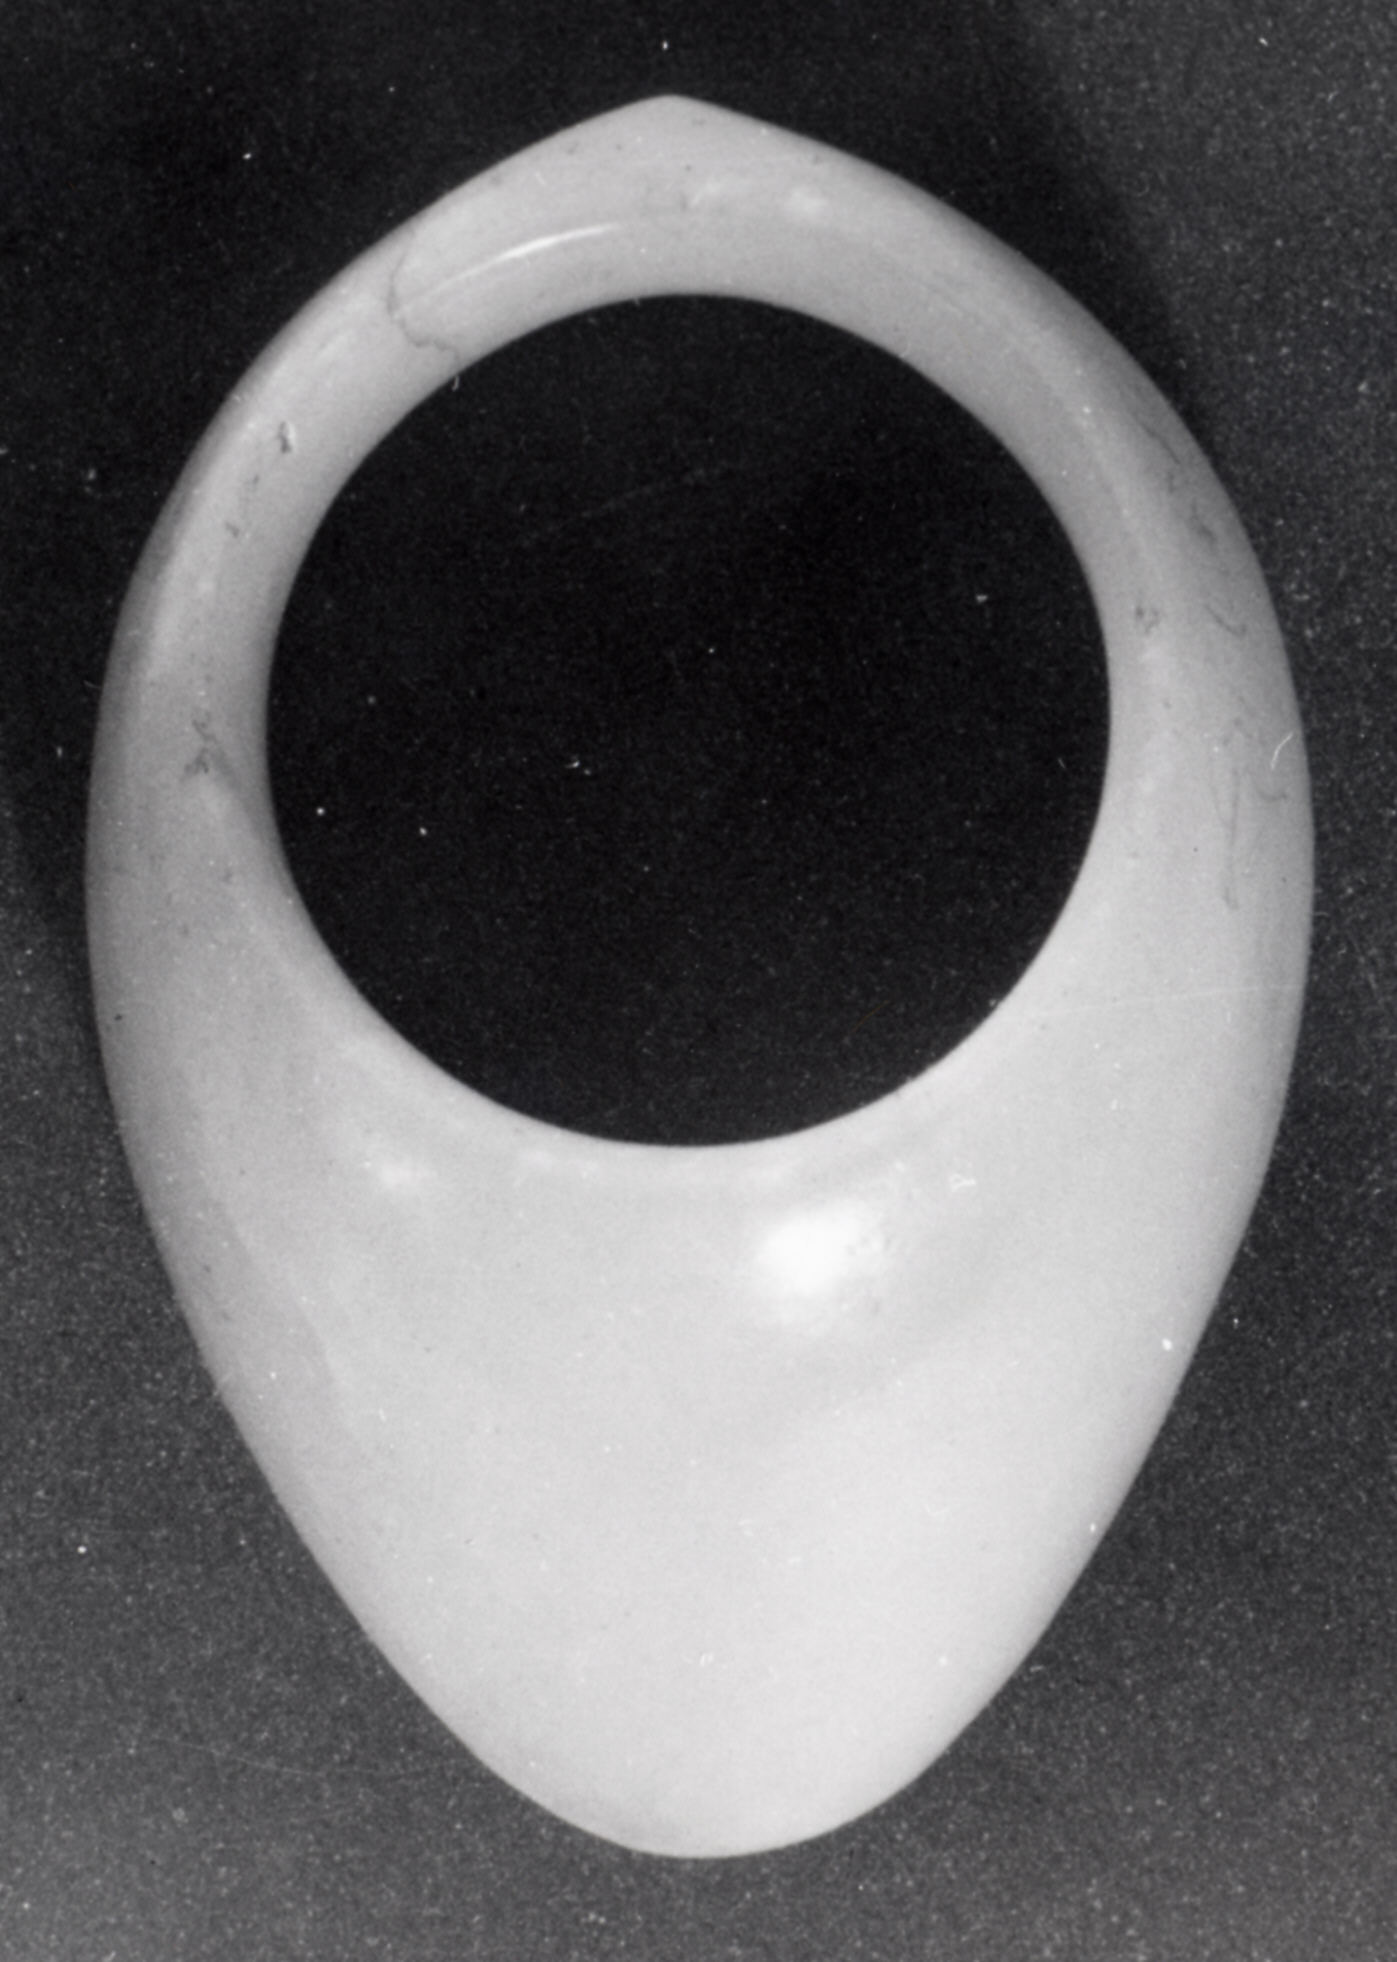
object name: archer's ring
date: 1601-1700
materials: jade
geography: india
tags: military equipment